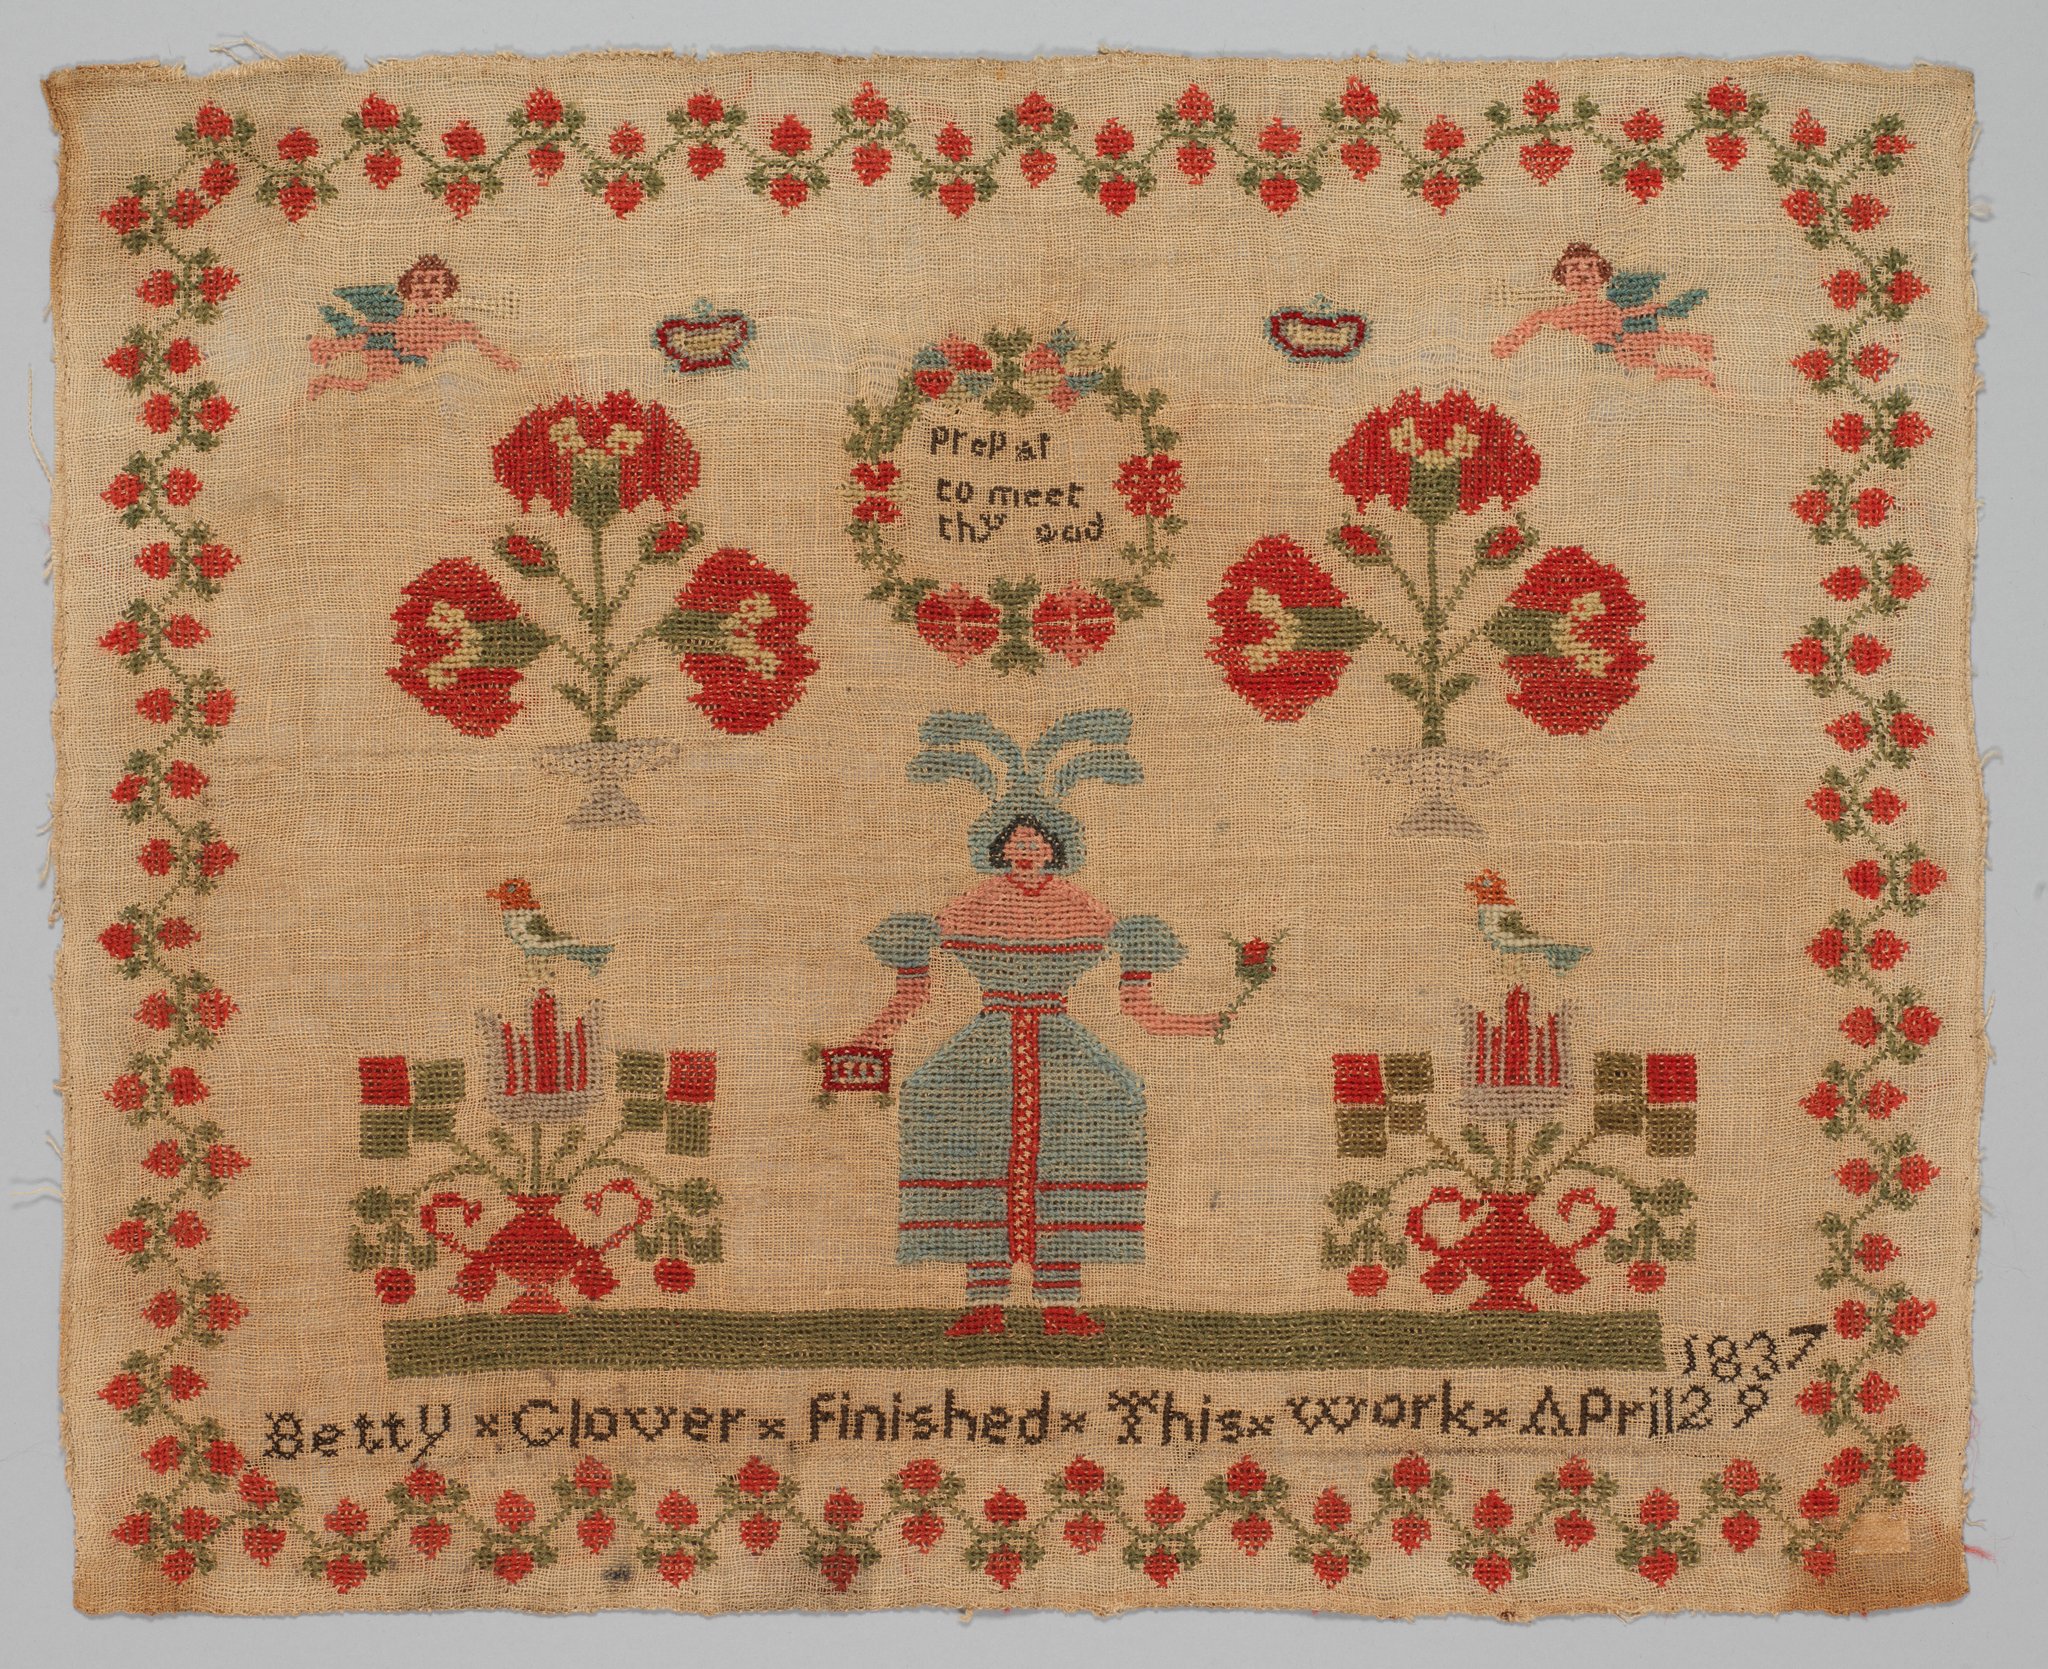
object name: sampler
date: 1837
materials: canvas, linen, silk, wool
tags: birds,women,flowers